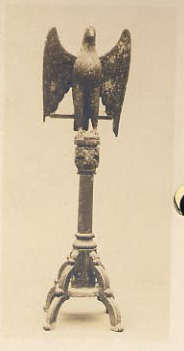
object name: lectern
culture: french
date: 1401-1500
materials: wood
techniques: polychromy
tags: eagles